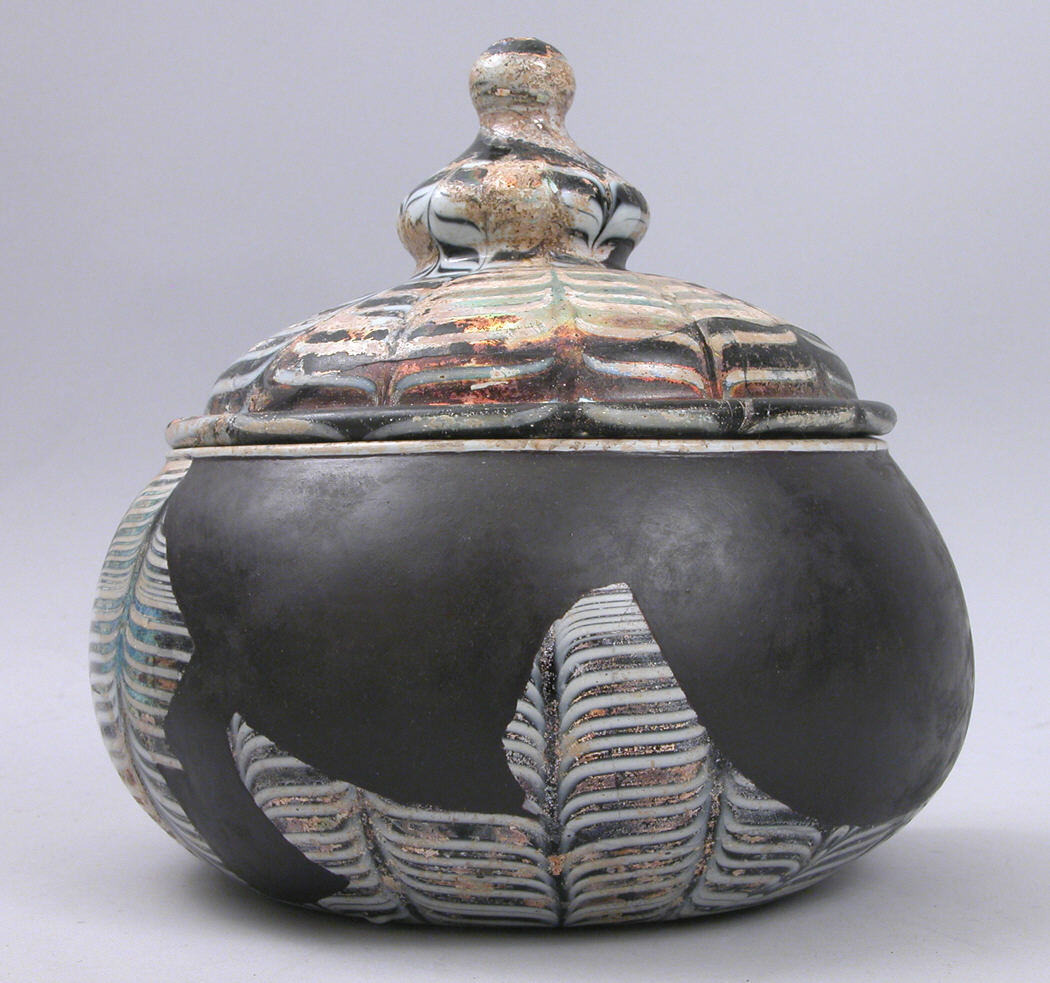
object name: bowl with lid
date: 1251-1300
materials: glass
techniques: glassblowing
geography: syria